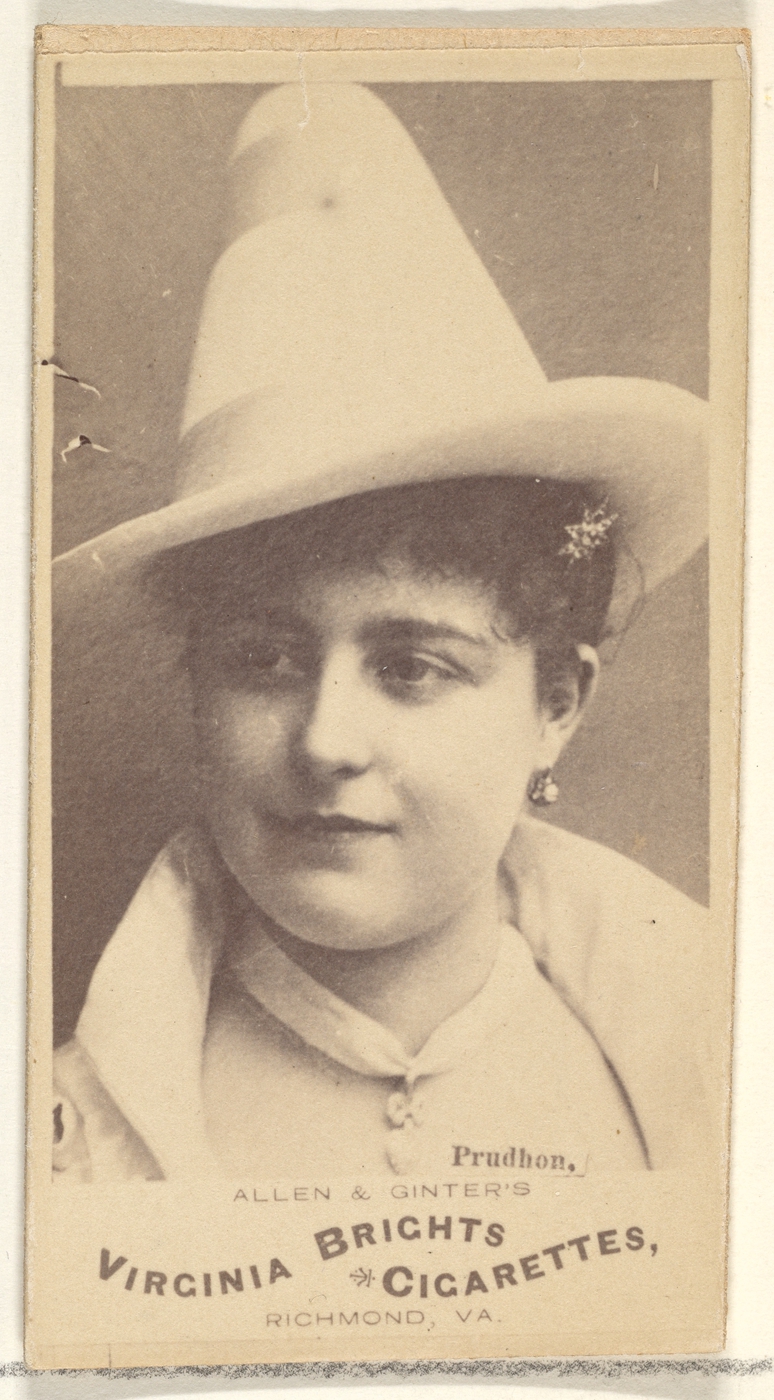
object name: photograph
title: Prudhon, from the Actors and Actresses series (N45, Type 1) for Virginia Brights Cigarettes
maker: allen & ginter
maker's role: publisher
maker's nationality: american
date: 1888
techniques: albumen silver print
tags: portraits,women,actresses